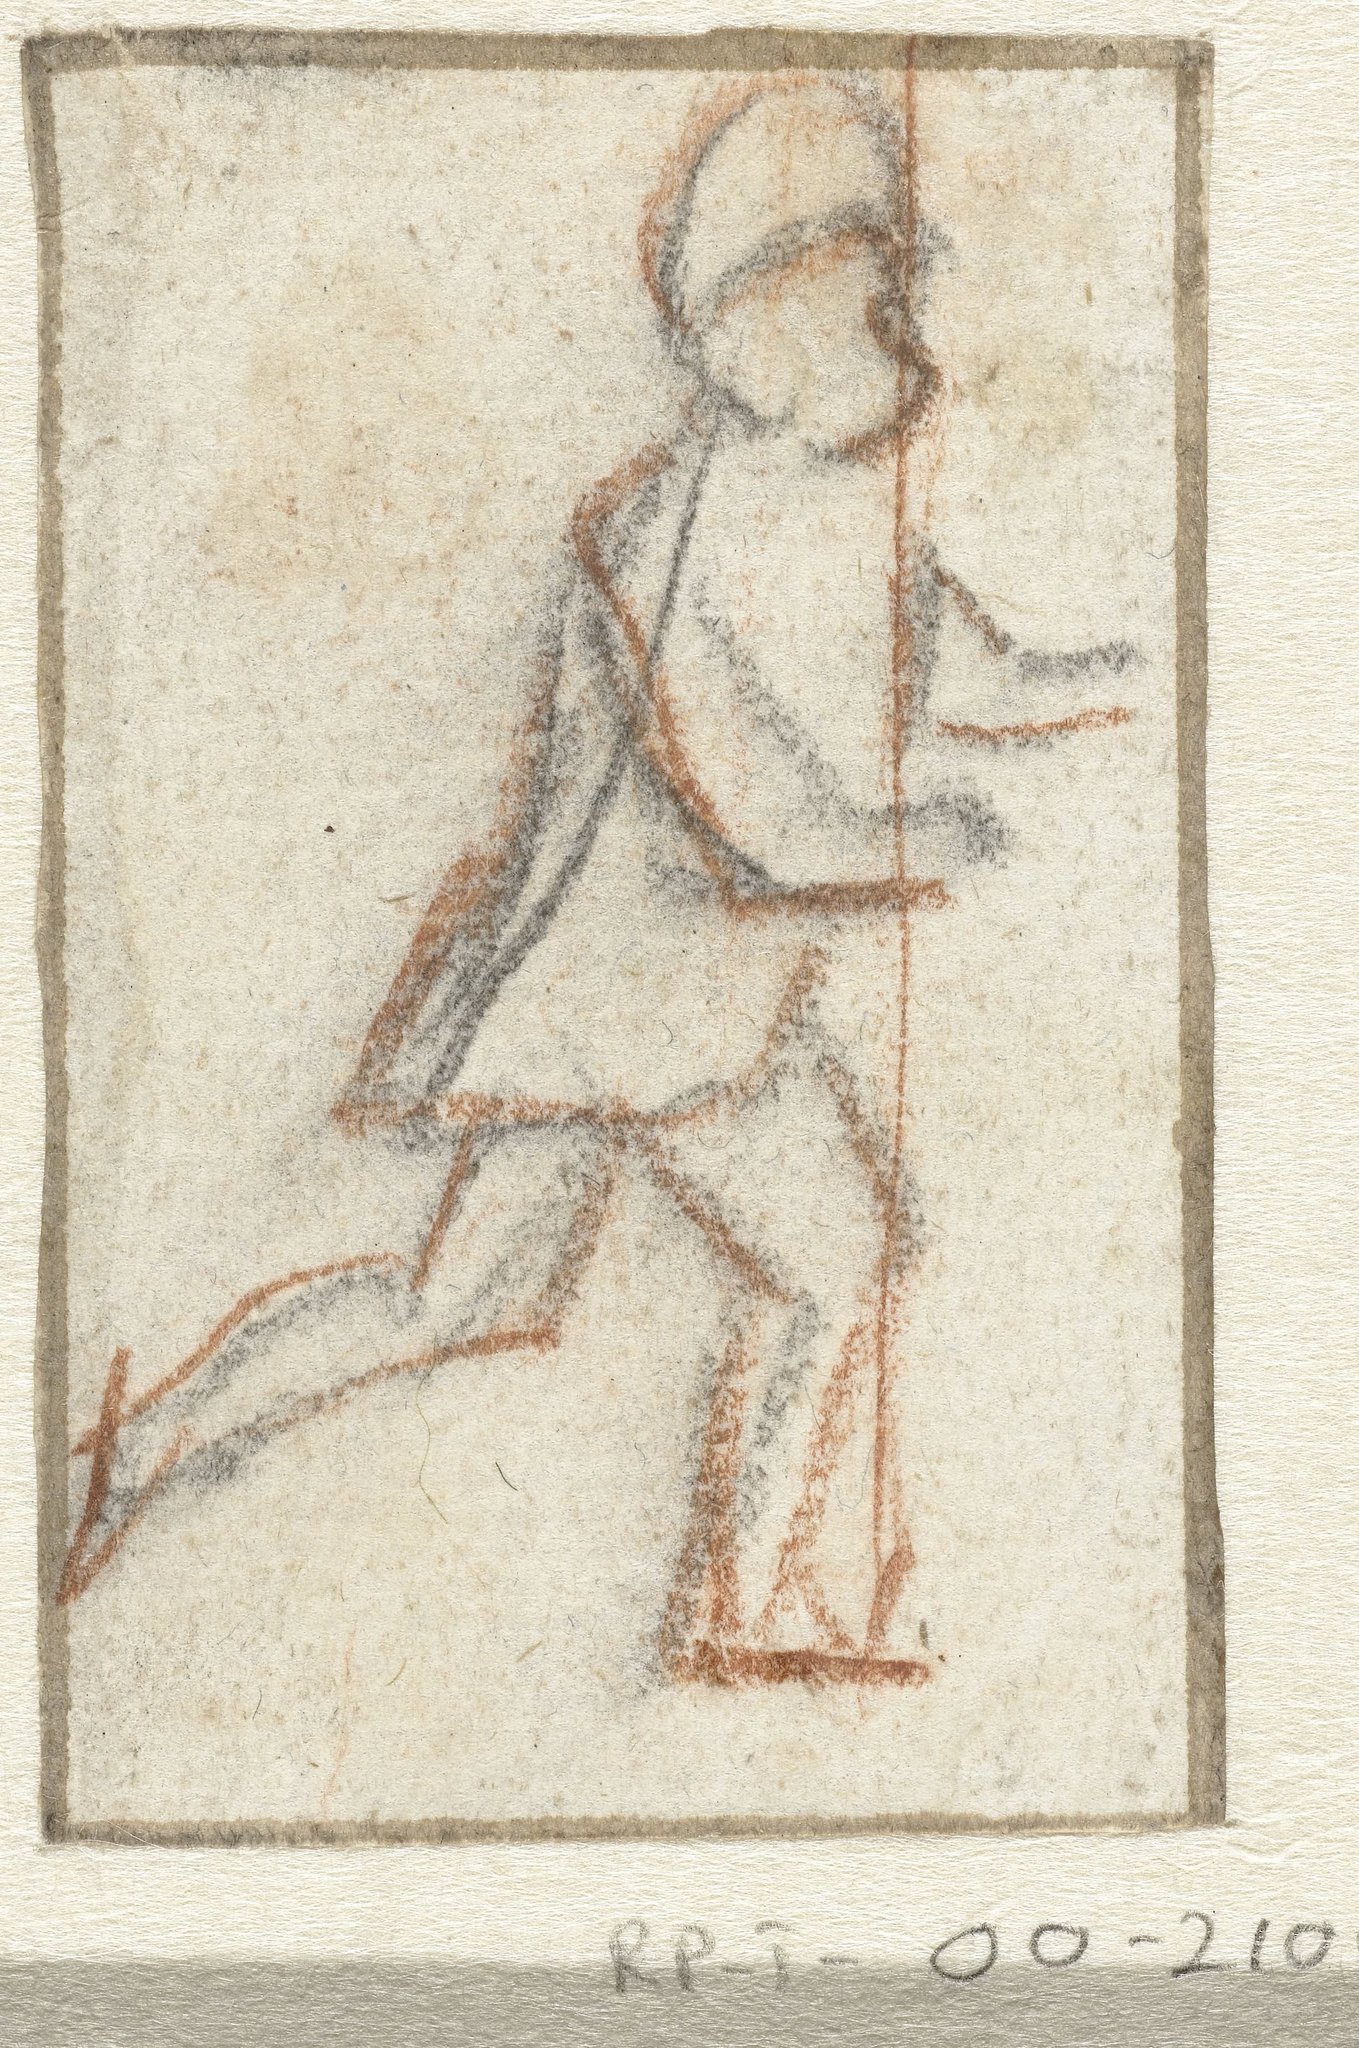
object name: drawing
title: Lopend mannetje, naar rechts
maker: simon andreas krausz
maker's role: draughtsman, print maker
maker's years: 1760-1825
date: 1770-1825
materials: chalk, paper